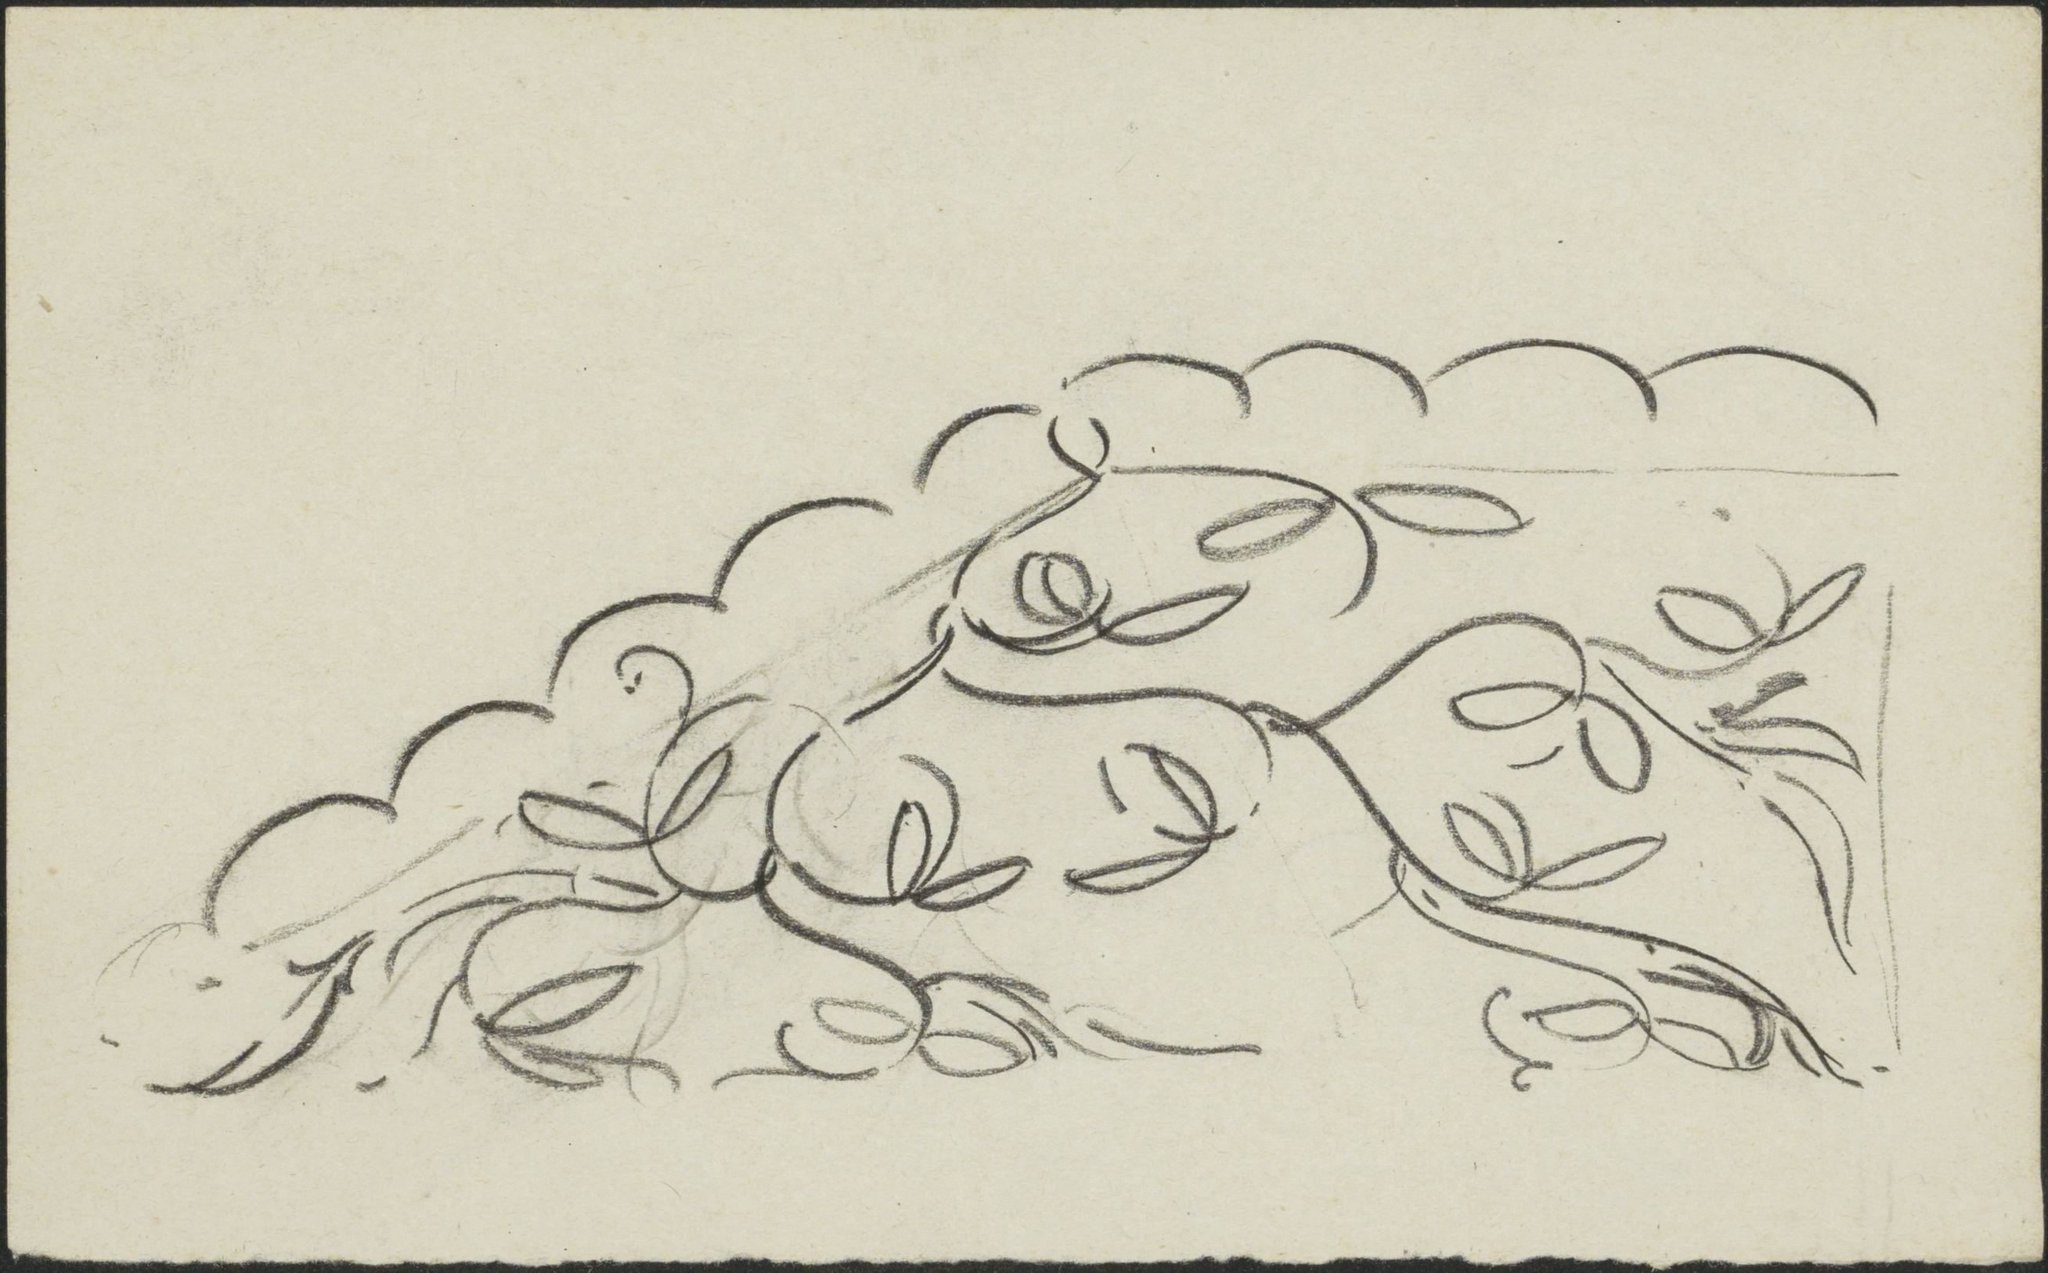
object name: drawing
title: Ornament met bladeren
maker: gerrit willem dijsselhof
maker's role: designer, draughtsman, print maker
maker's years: 1866-1924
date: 1876-1924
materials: chalk, paper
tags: foliage, tendrils, branches ~ ornament